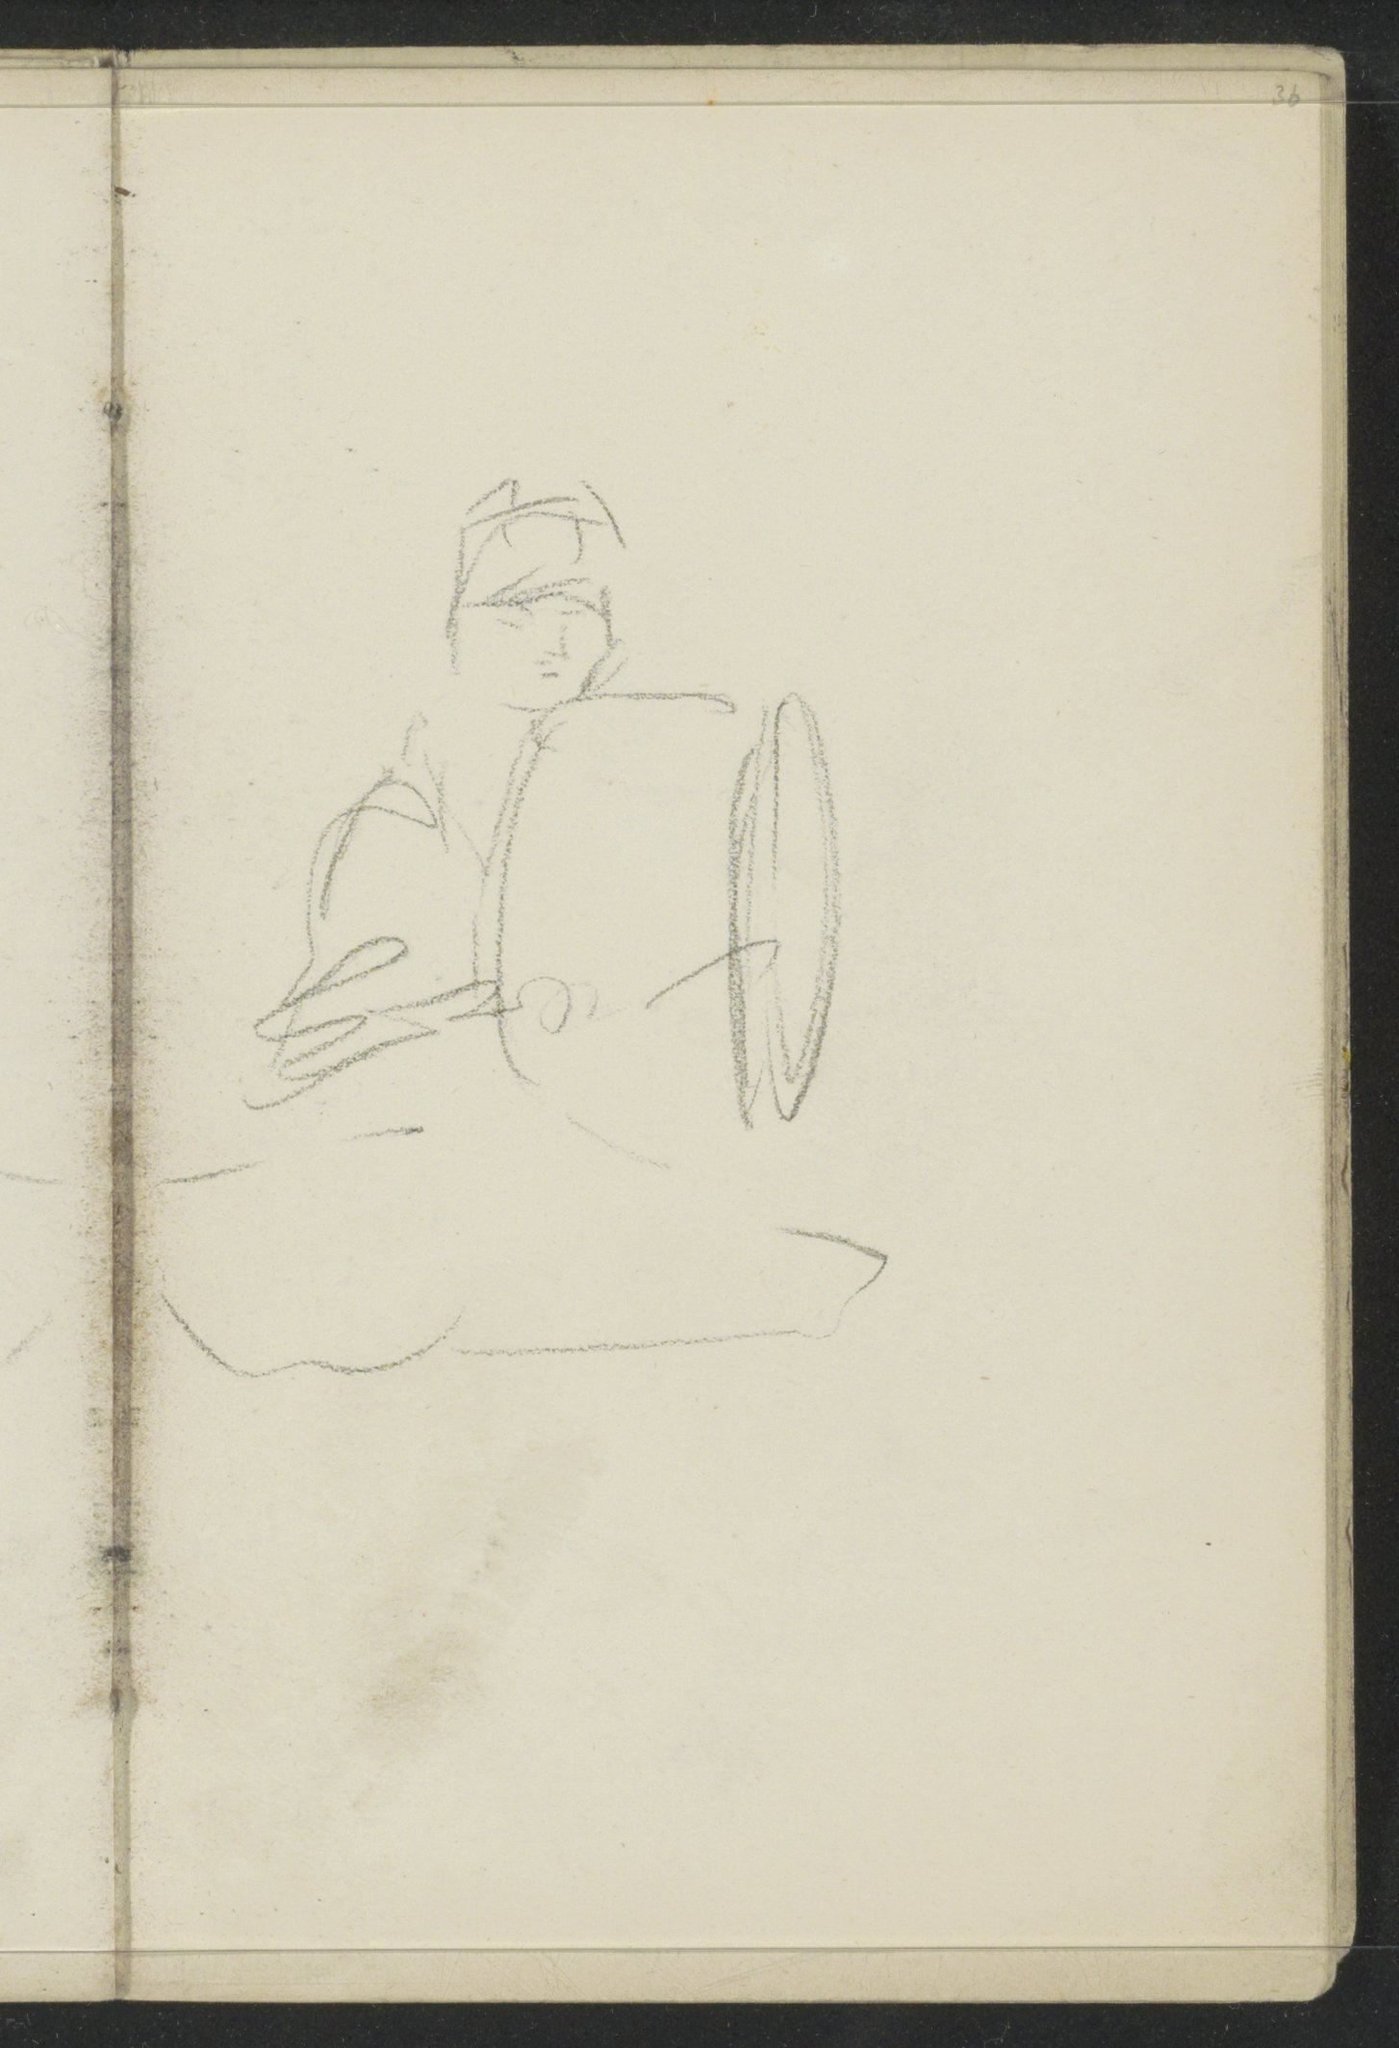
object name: sketchbook leaf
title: Zittende figuur met een trommel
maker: isaac israels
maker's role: draughtsman, painter, print maker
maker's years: 1865-1934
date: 1887-1934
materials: paper, pencil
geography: paris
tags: adult man (+ sitting), drum (musical instrument)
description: Mogelijk oosters. Pagina 36 uit schetsboek XXXIX met 51 pagina's.